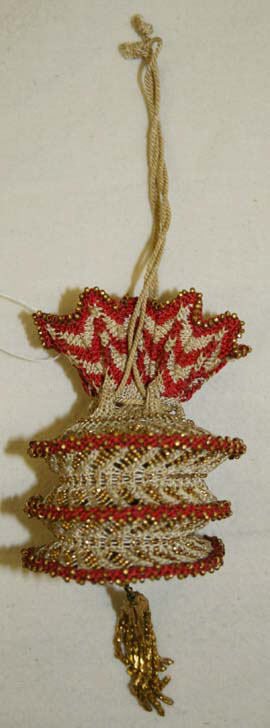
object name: reticule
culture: european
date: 1810-1825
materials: metal, silk